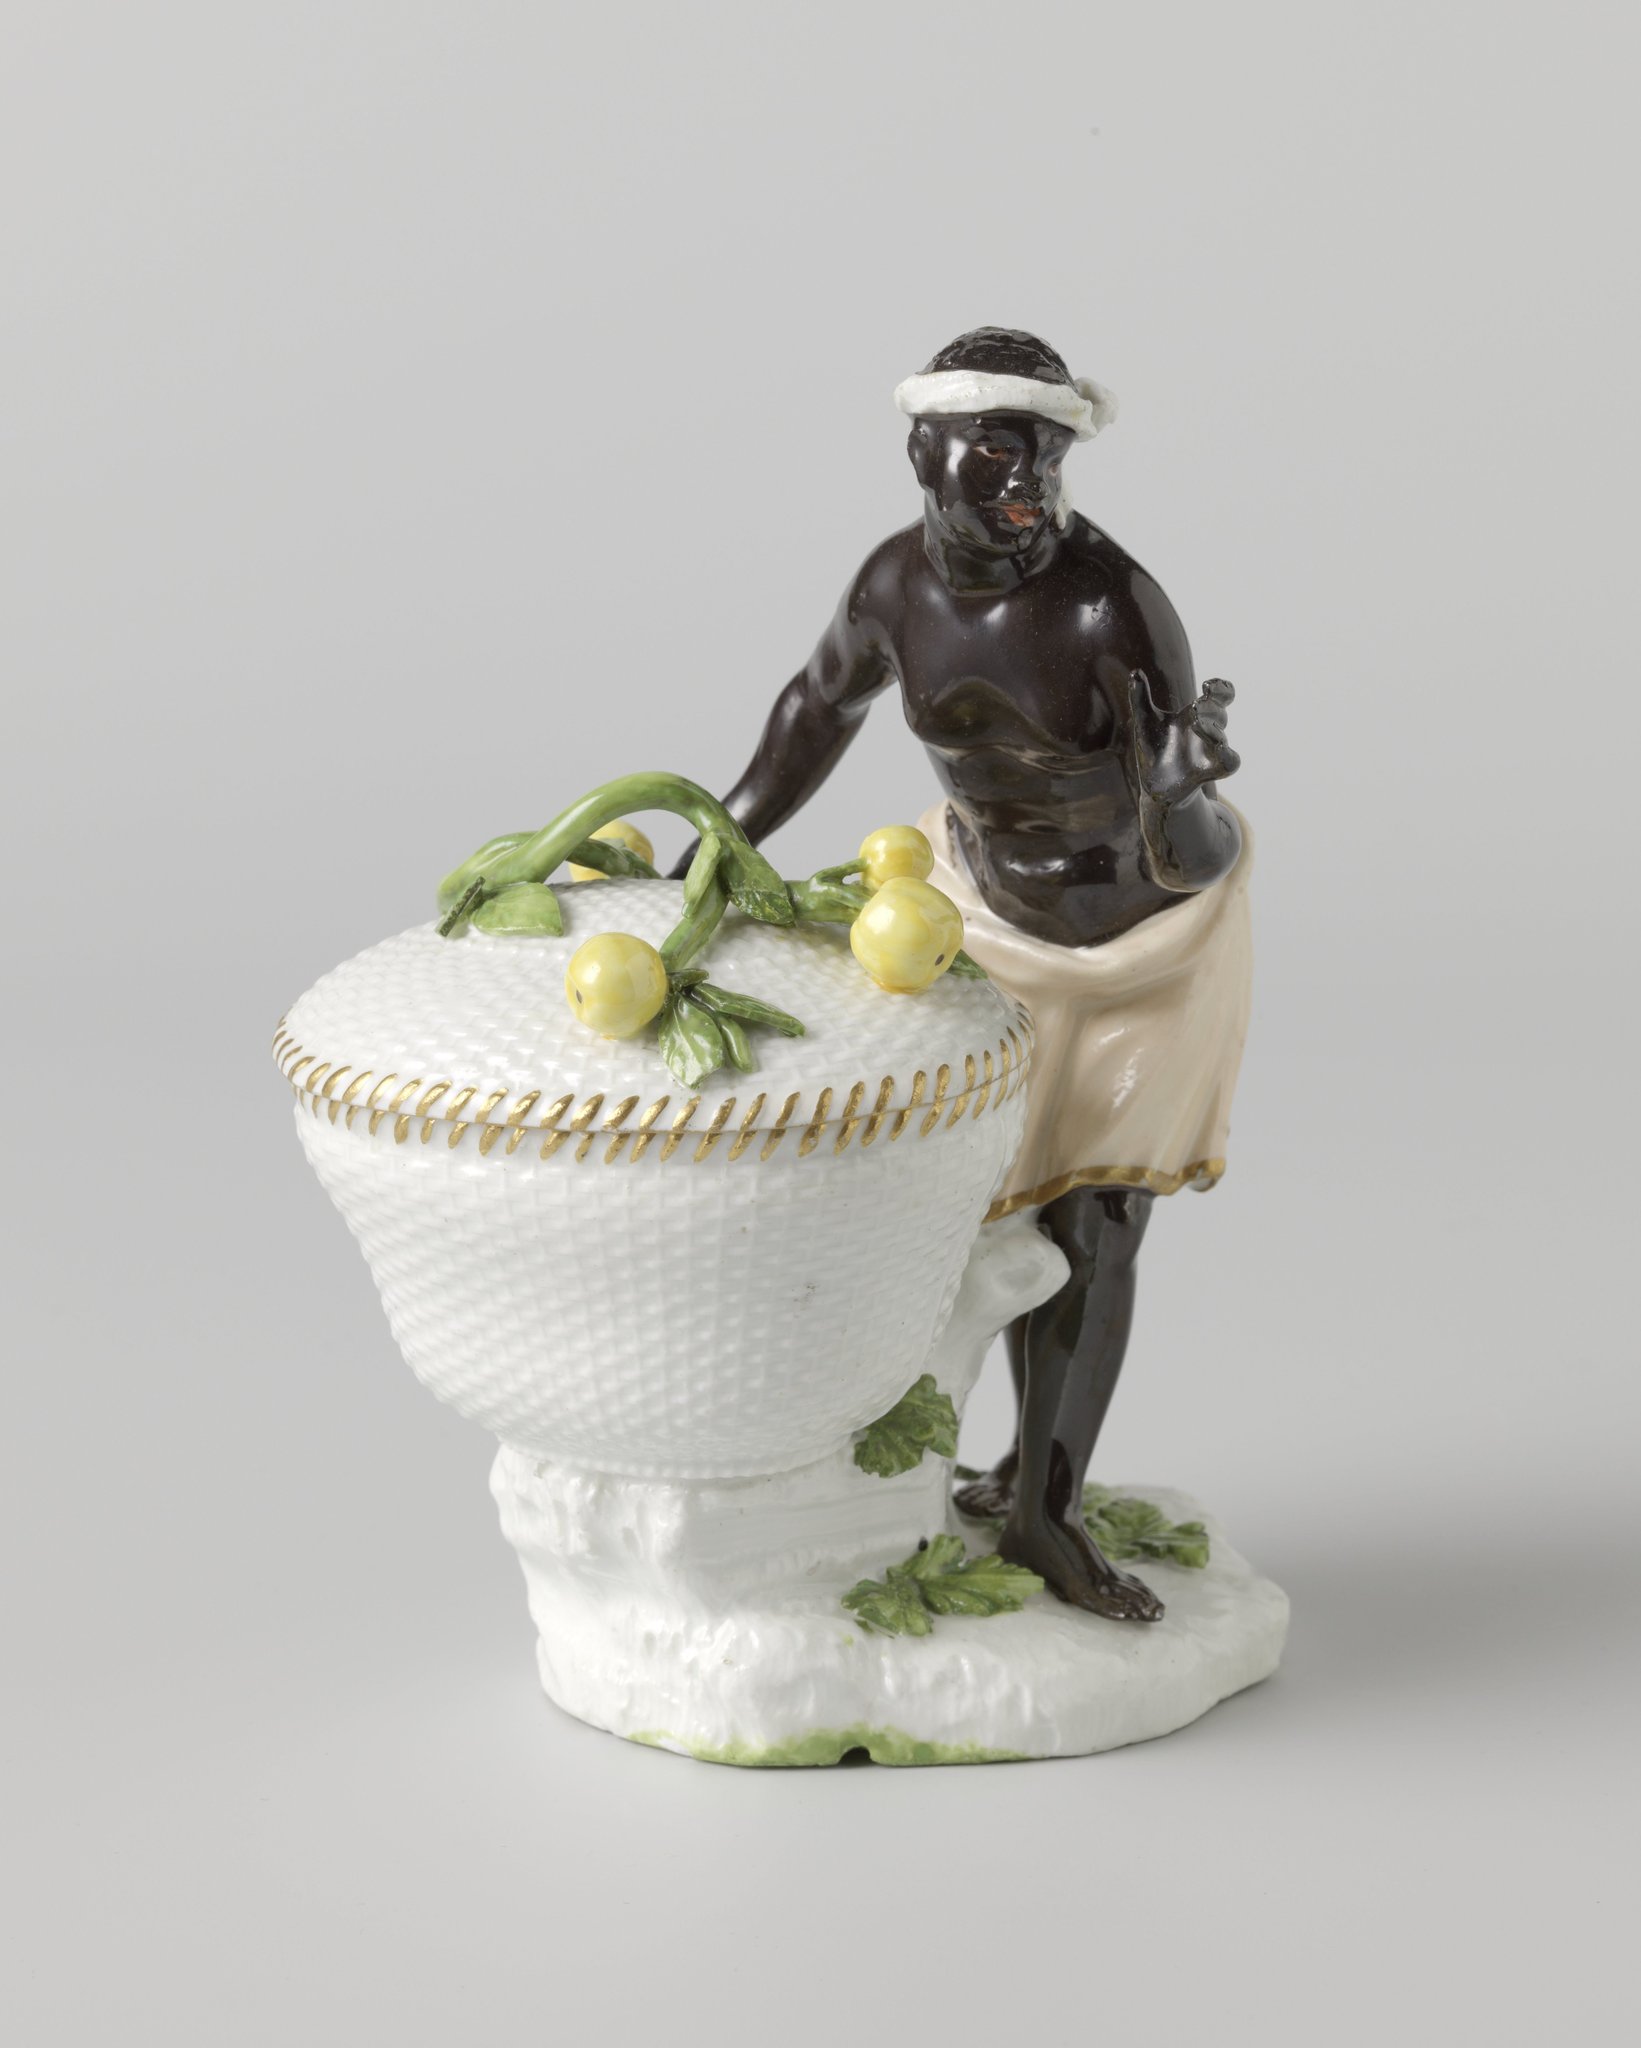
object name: eating drinking utensil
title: Suikerpot in de vorm van een vrouw bij een mand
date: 1741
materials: porcelain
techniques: painted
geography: meissen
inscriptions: factory mark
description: Suikerpot van porselein, in de vorm van een vrouw met naast zich een mand met deksel op een grond met bladeren. De vrouw draagt een rose-beige rok met een gouden rand en een witte hoofddoek om het haar. Op het deksel van de mand is een tak met citroenen aangebracht. De binnenkant van de mand en het deksel zijn geheel verguld. Het beeld is gemerkt.